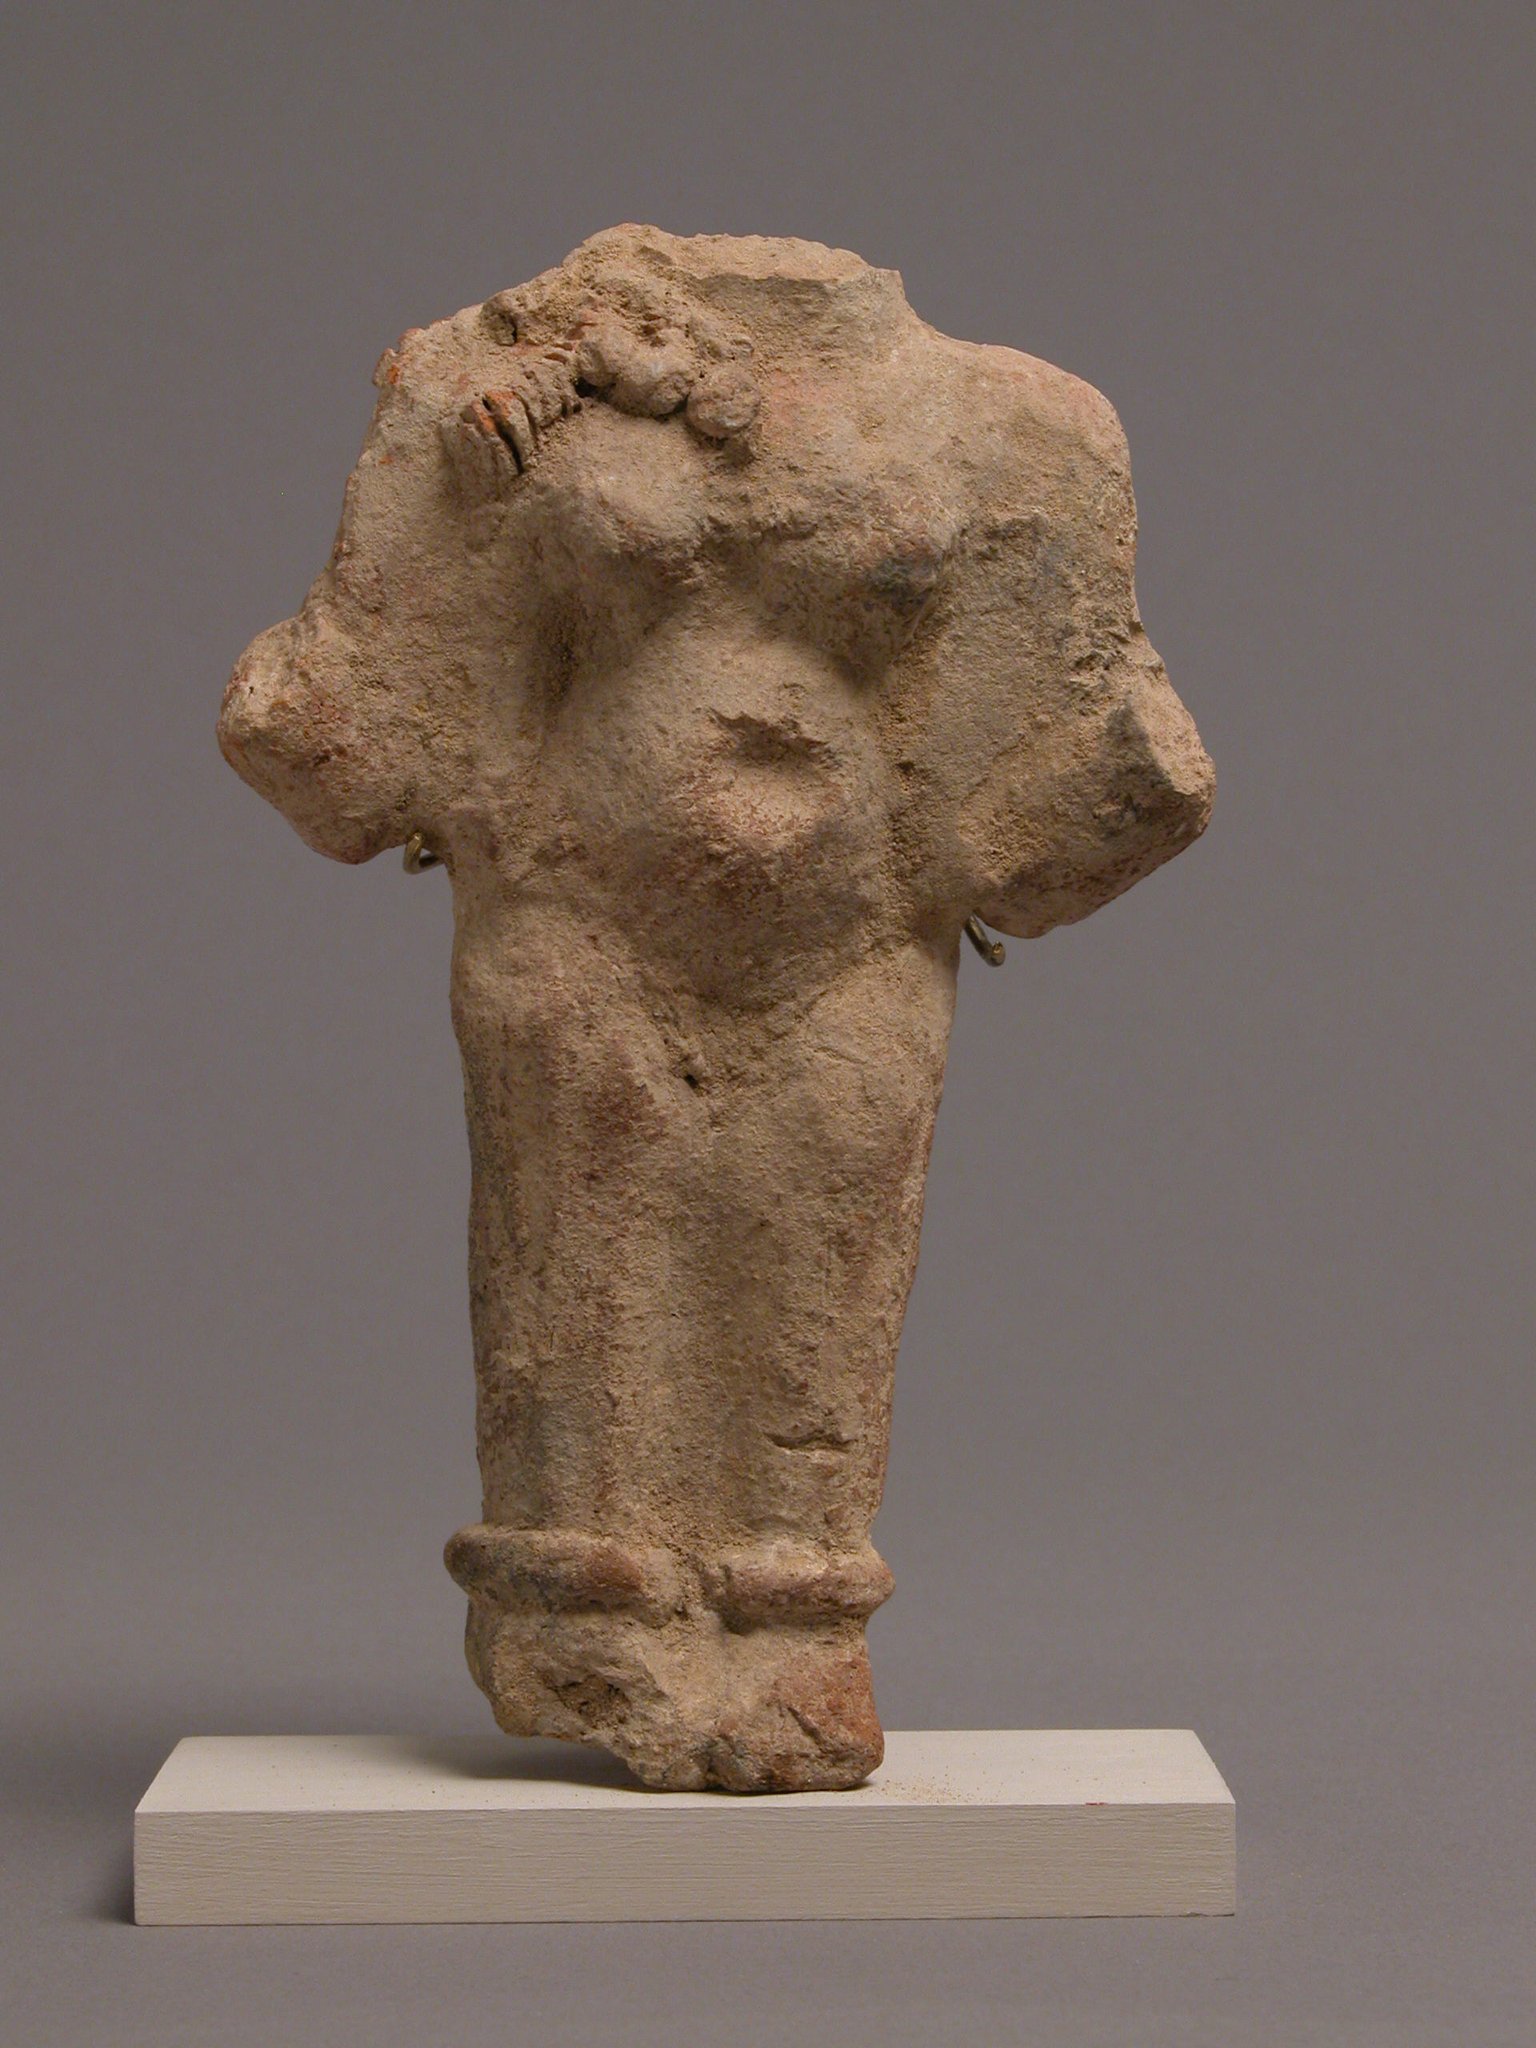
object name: statuette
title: Fragment of a Figure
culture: coptic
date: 301-700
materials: earthenware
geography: egypt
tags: women